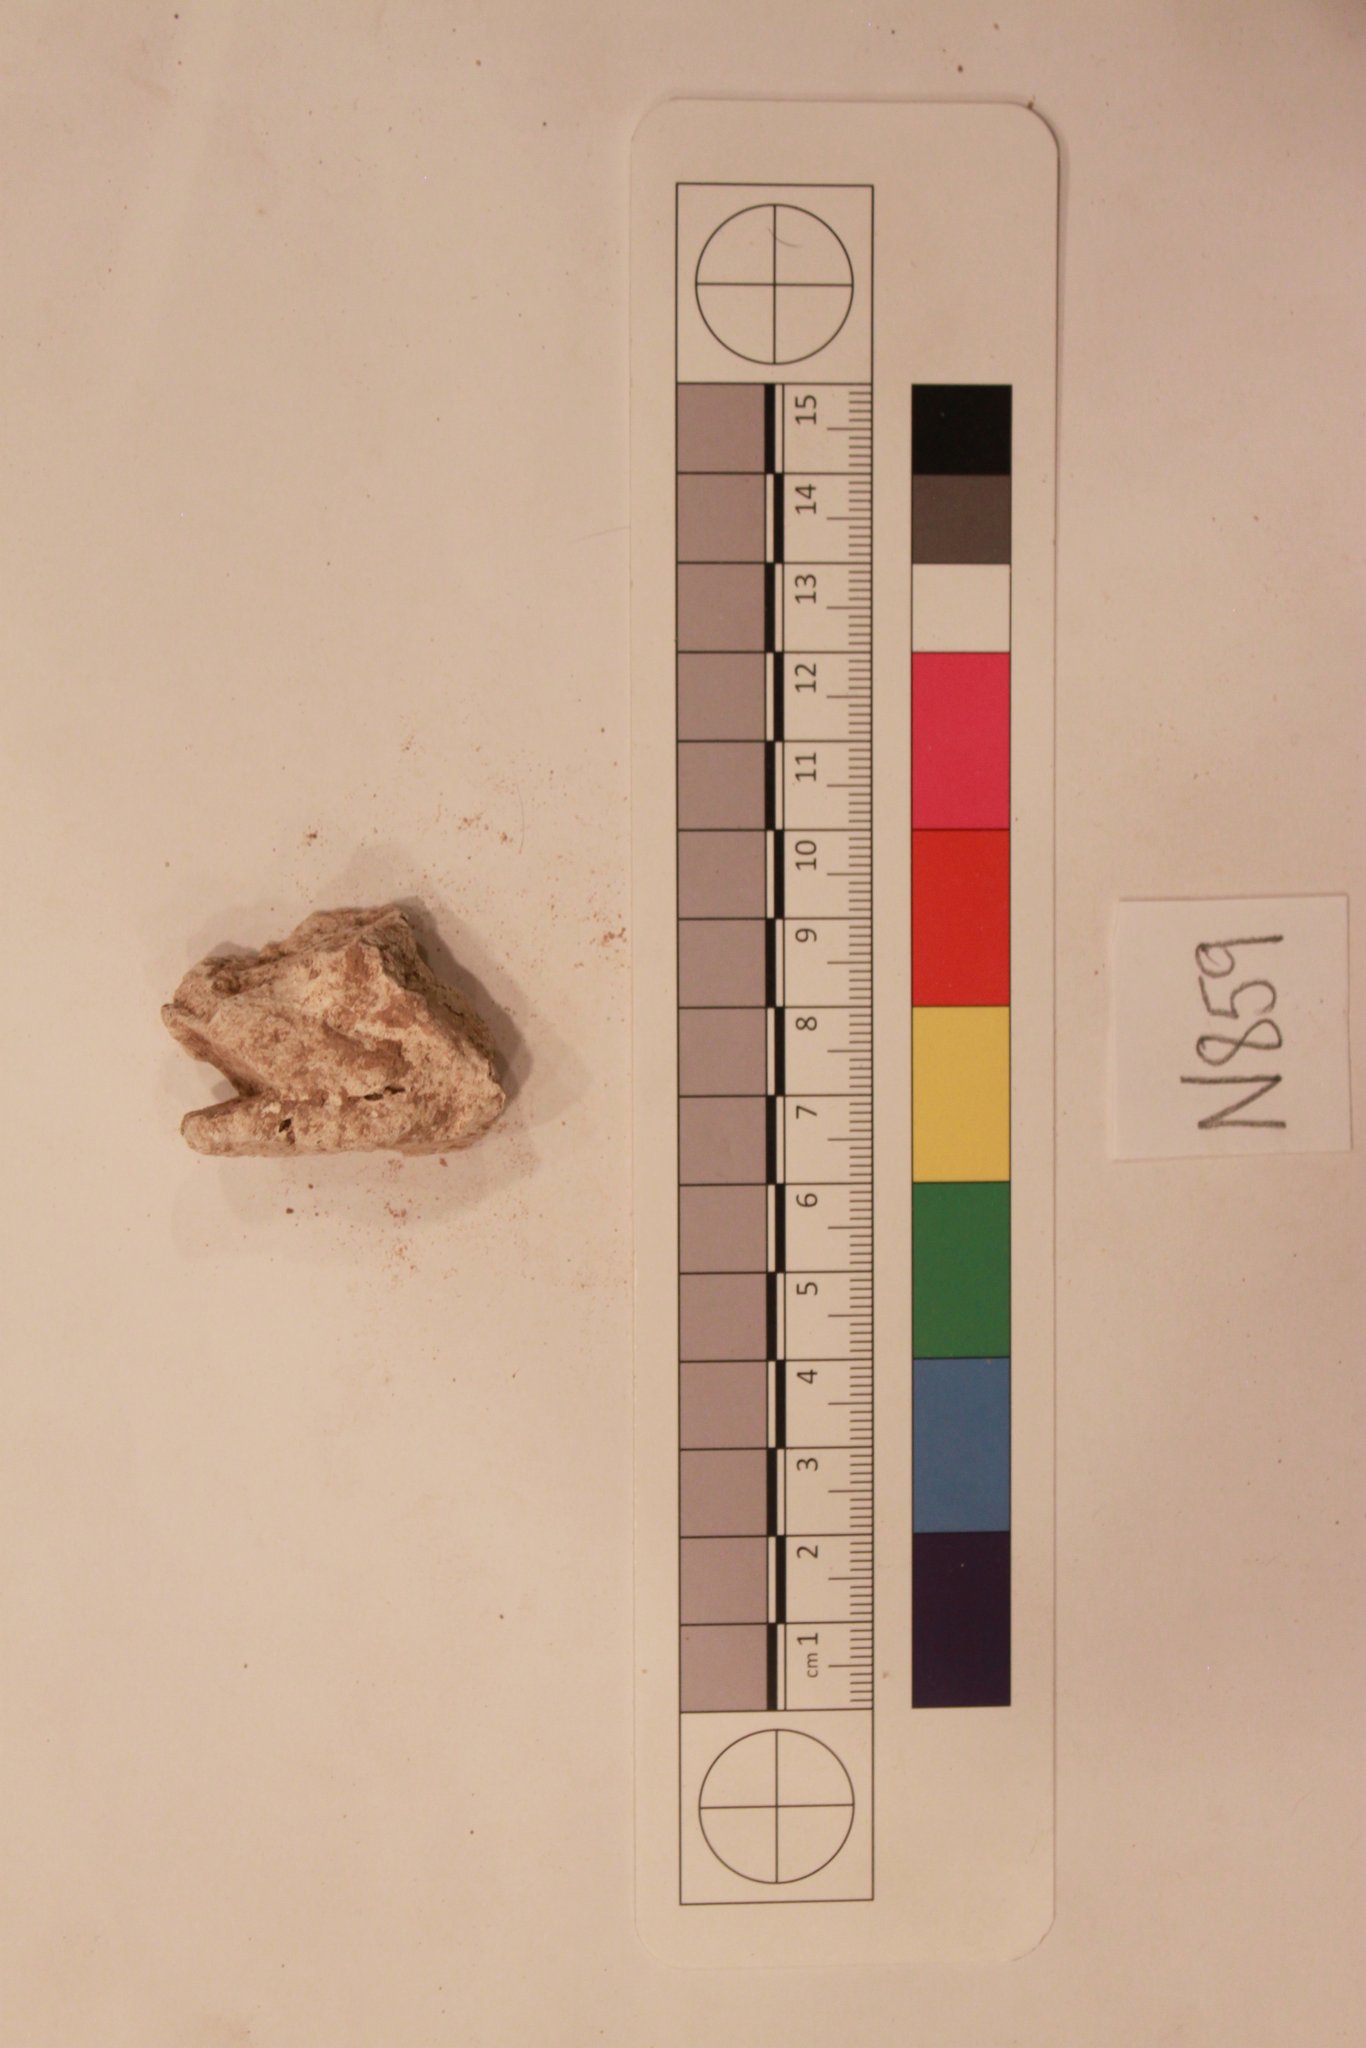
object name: fragment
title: Stucco Fragment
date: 701-1200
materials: plaster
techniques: carving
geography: iran